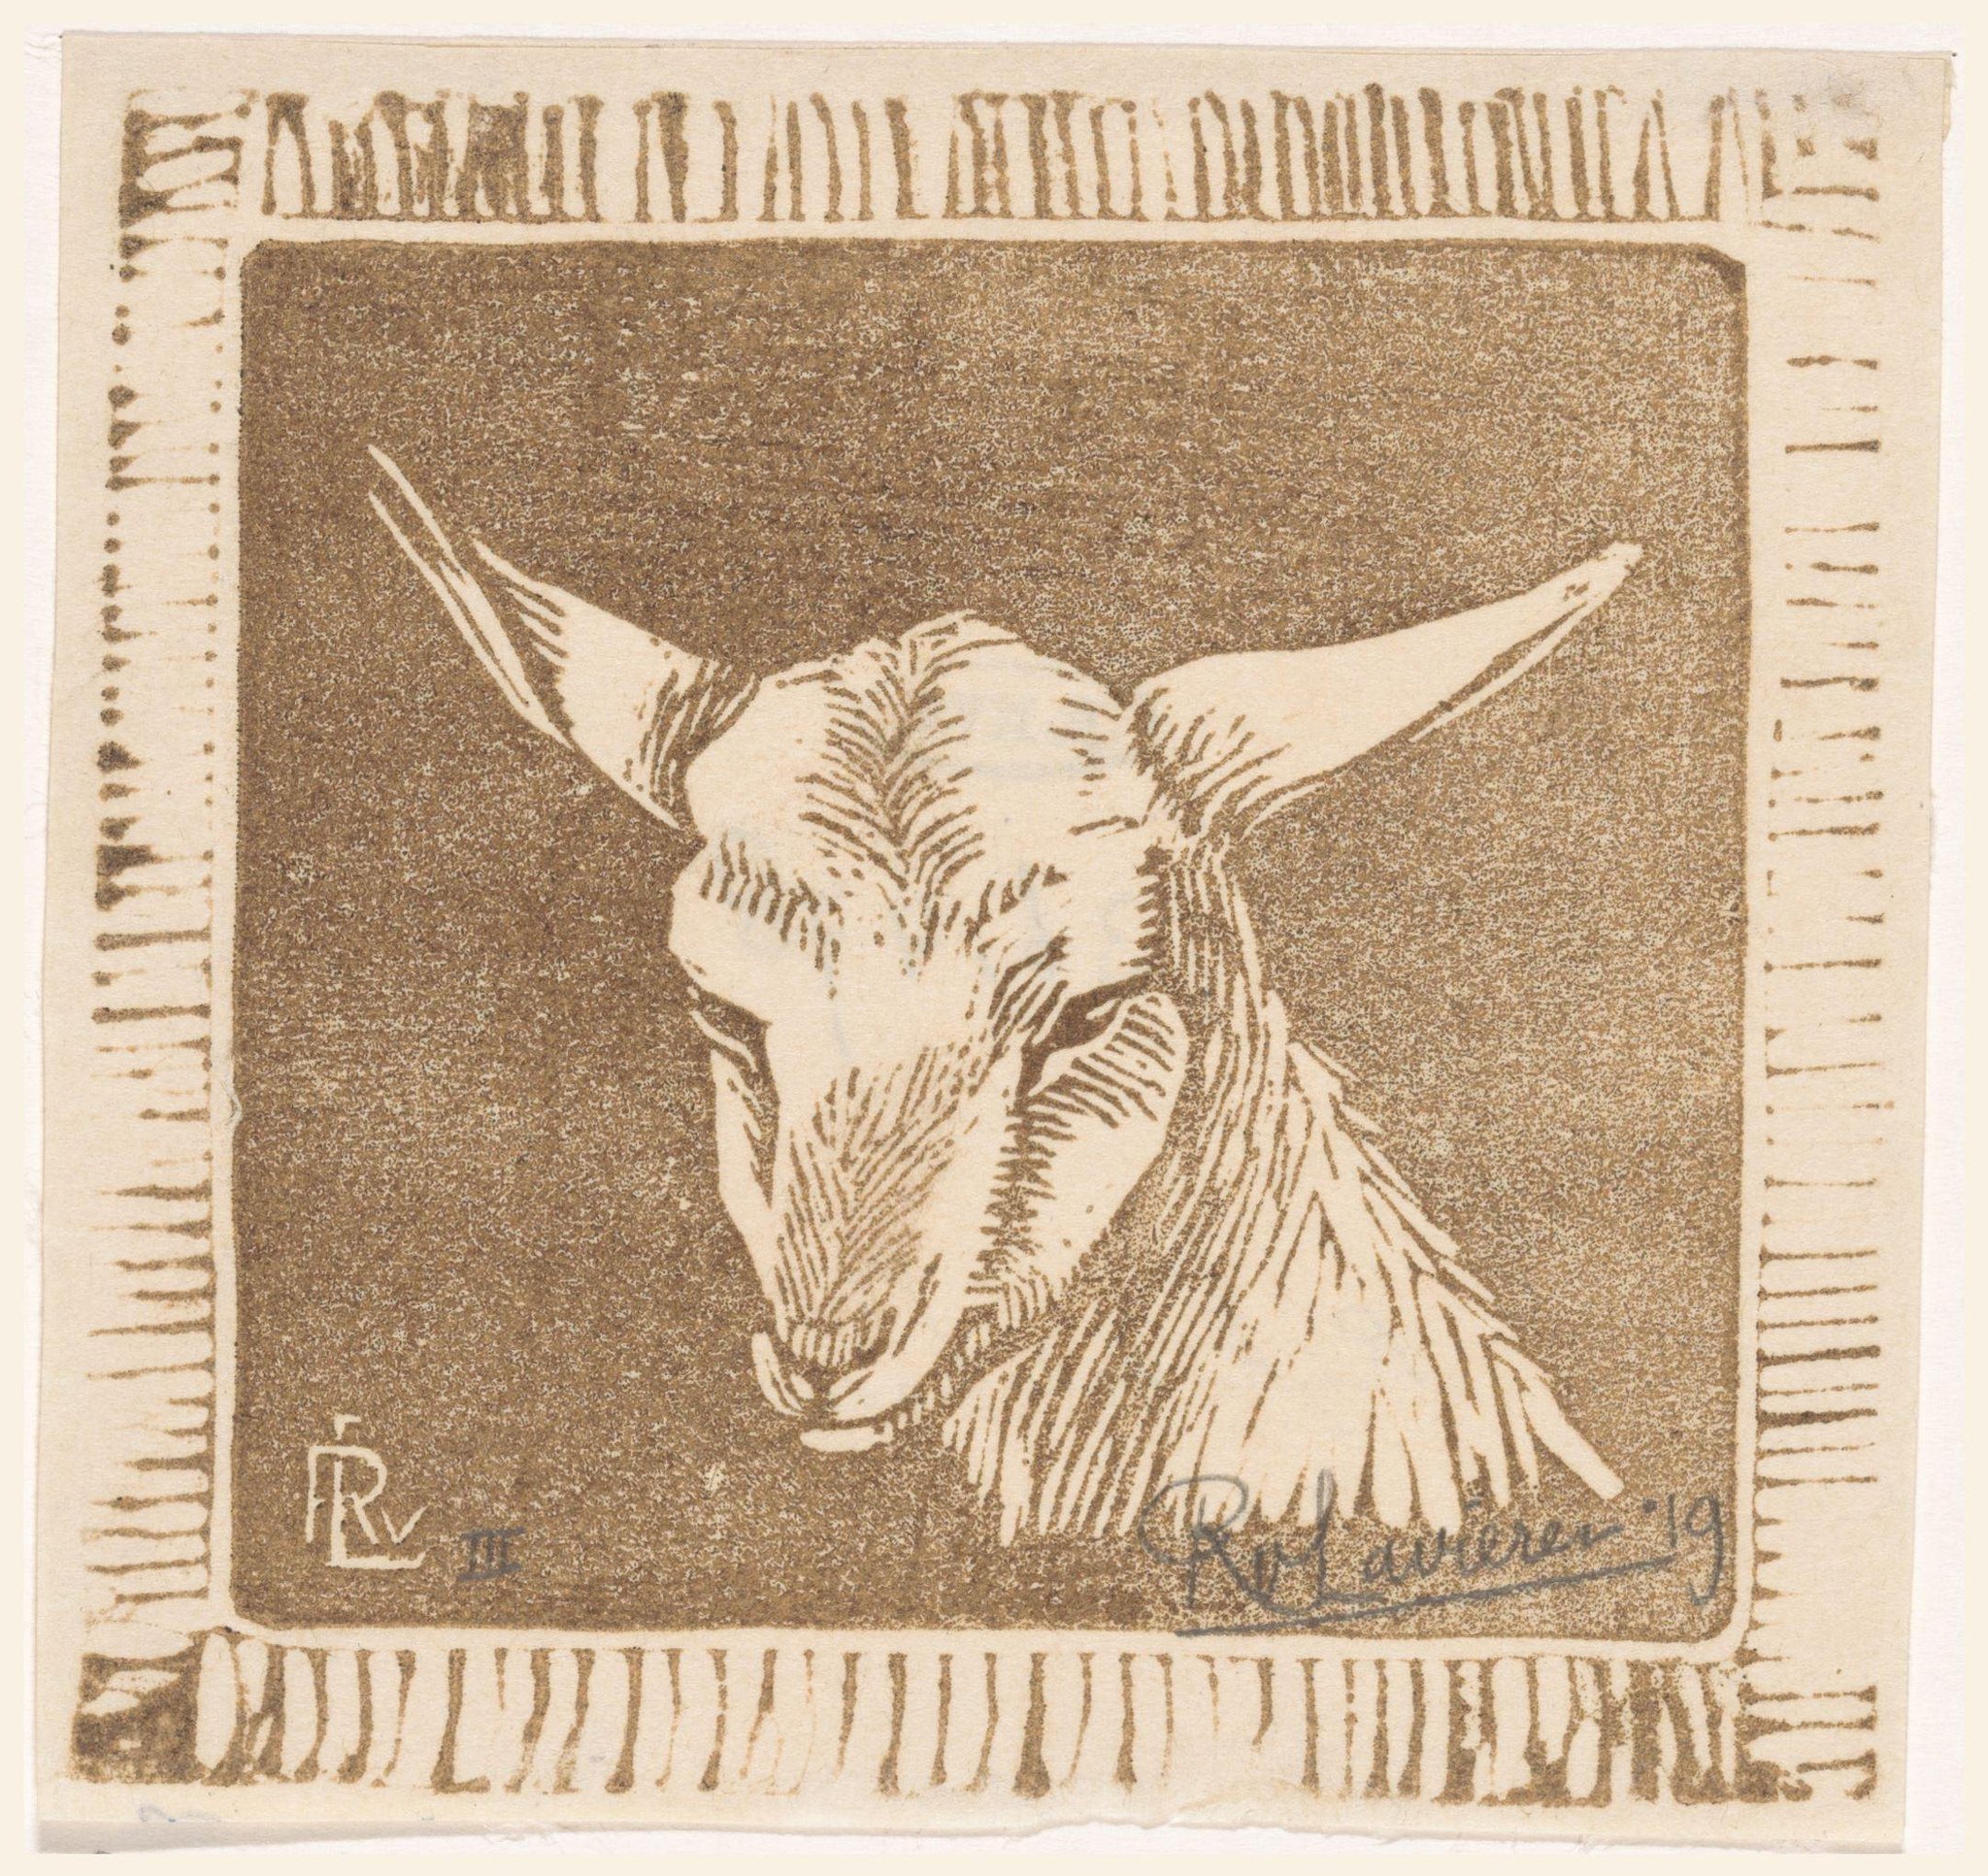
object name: print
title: Kop van een jonge geit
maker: rijk van lavieren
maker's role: print maker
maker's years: 1889-1952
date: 1919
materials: paper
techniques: woodcut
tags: kid (goat)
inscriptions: collector's mark: Lugt 2228, number: ‘III’, collector's mark: Lugt 2760